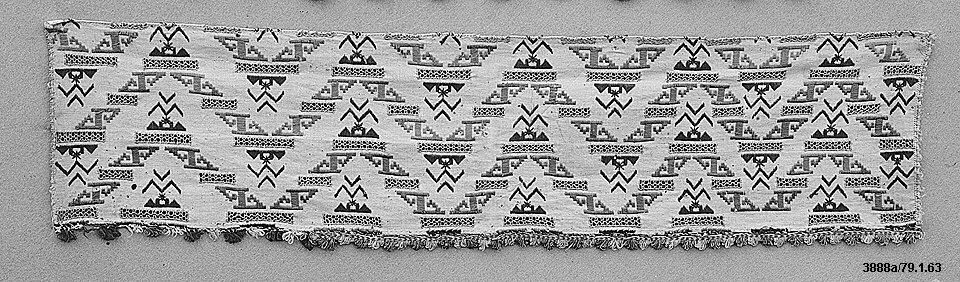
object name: border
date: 1701-1800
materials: linen, silk